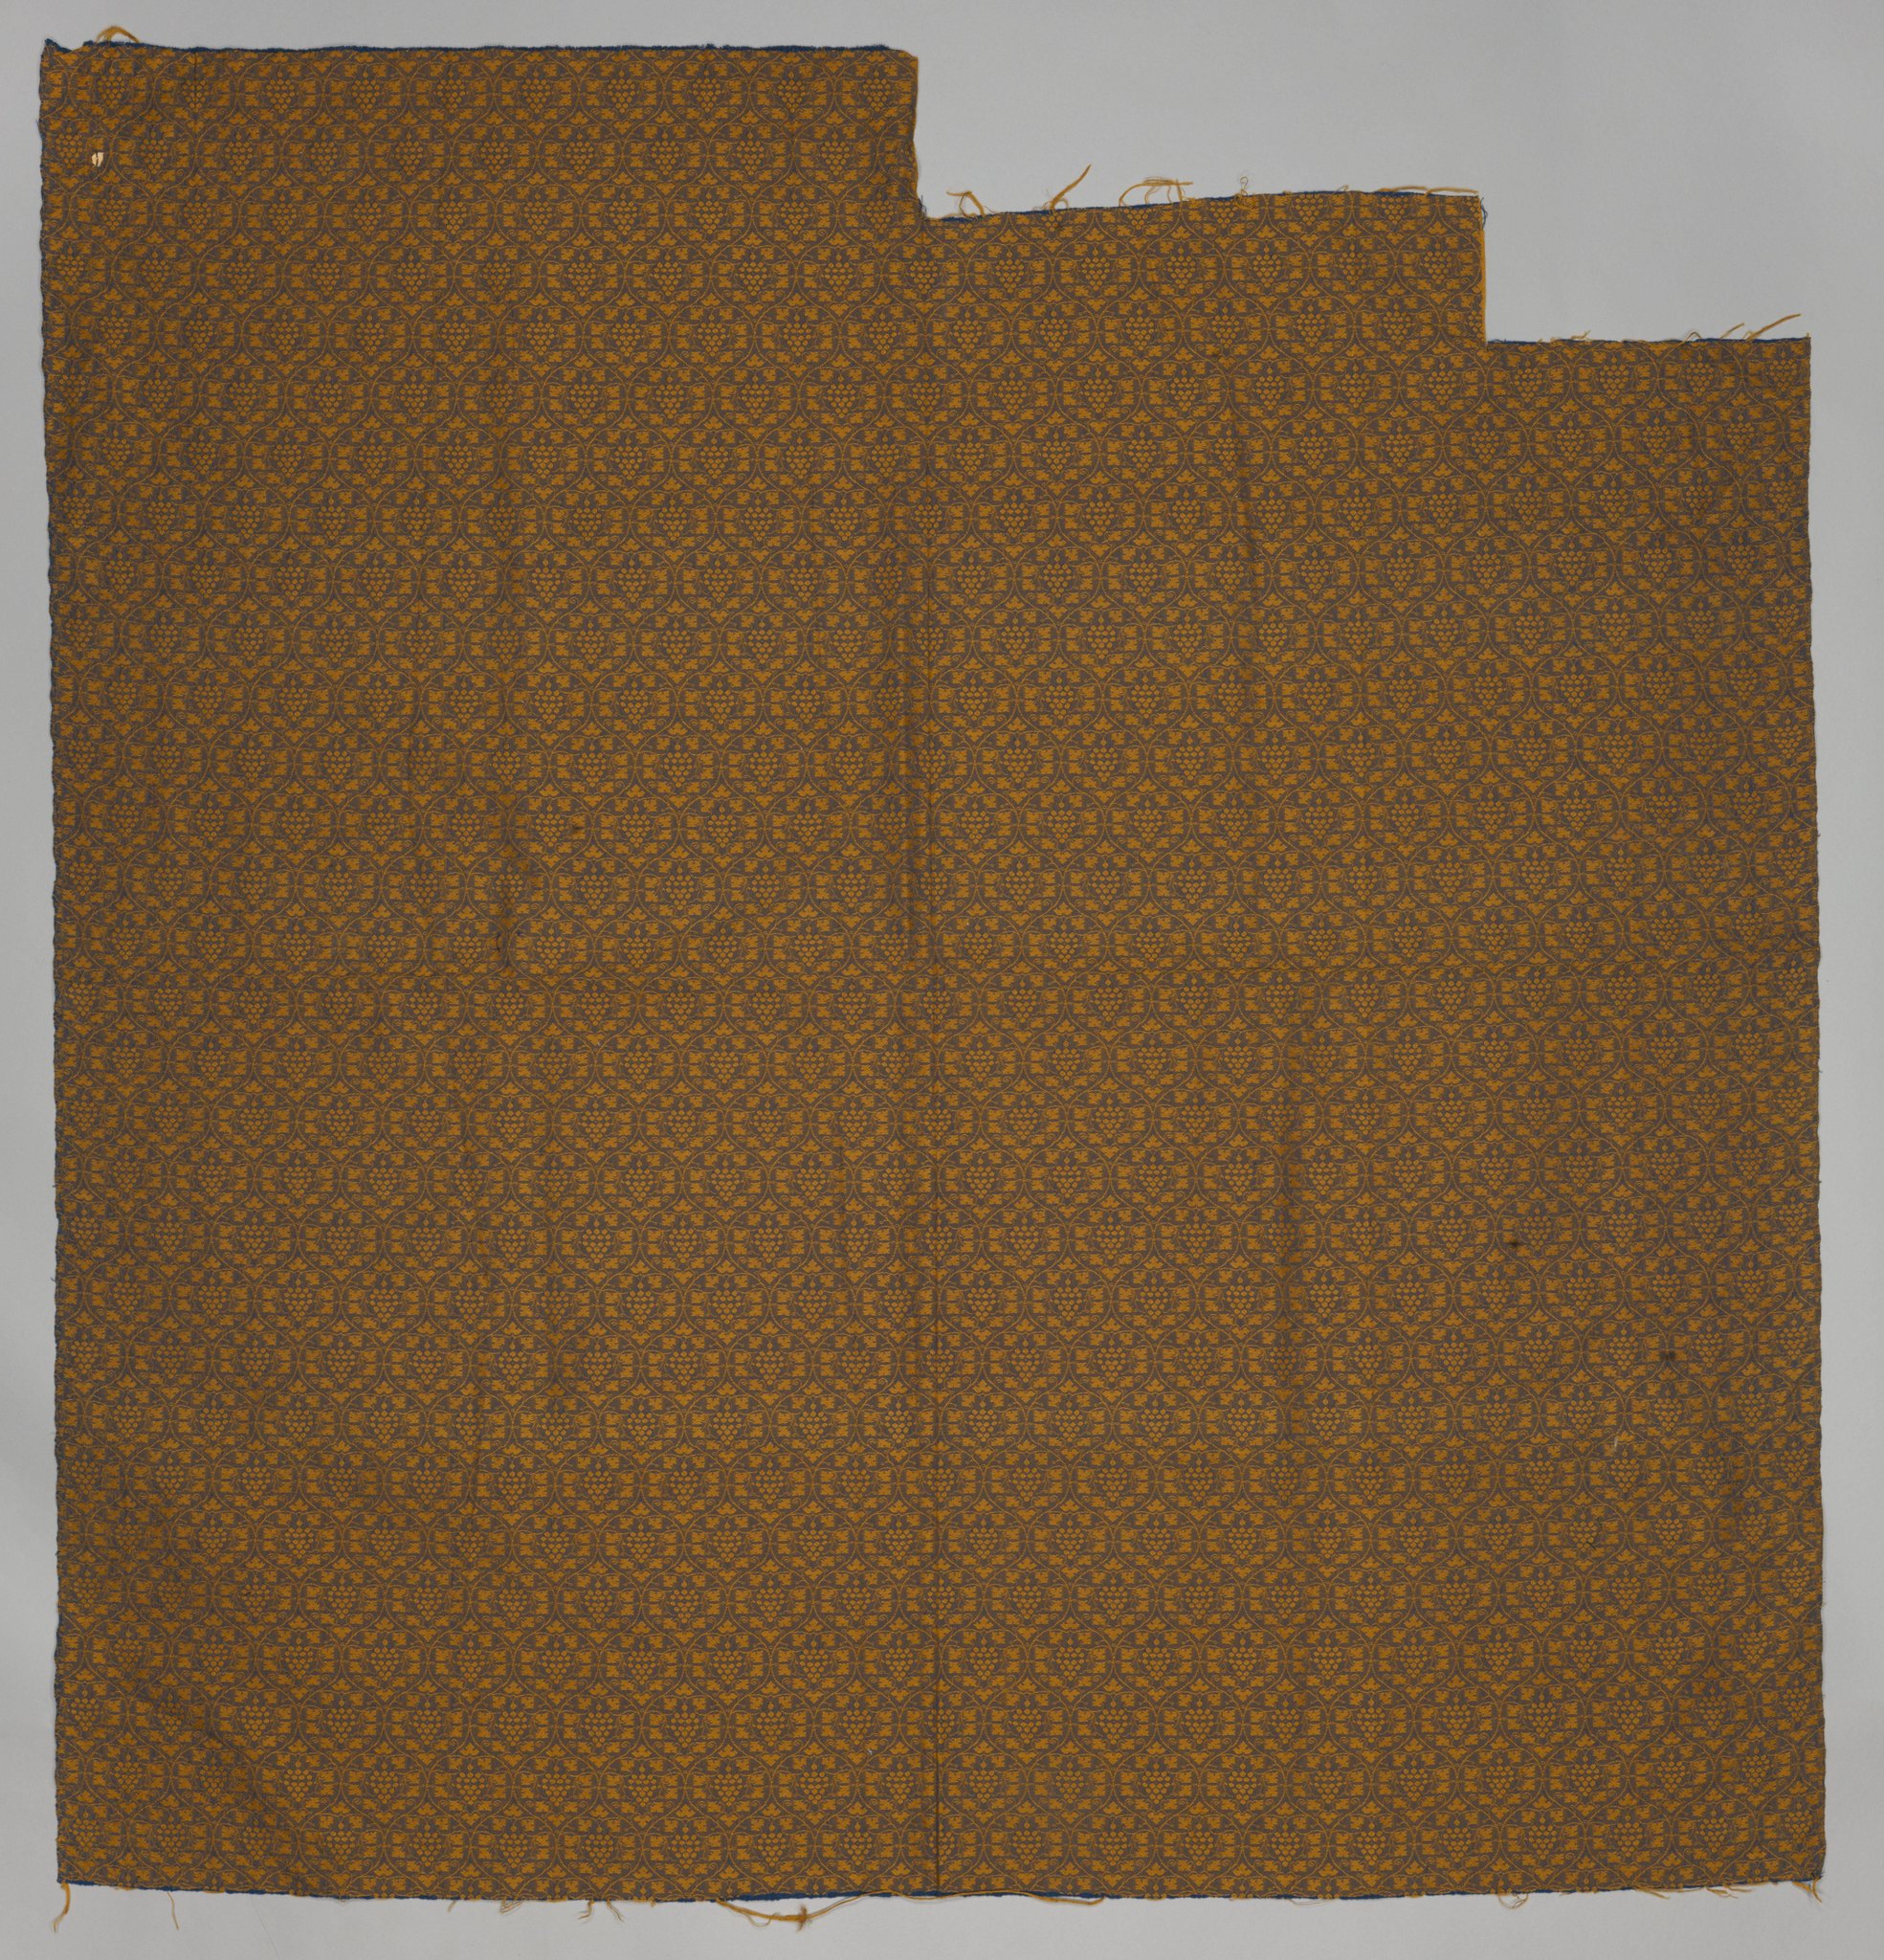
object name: upholstery fabric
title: Bespanningsstof, jacquardweefsel met patroon van spitsovalen met wingerdranken, goudgele inslag op blauwe ketting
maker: theo nieuwenhuis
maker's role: designer, draughtsman, print maker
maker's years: 1866-1951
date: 1920-1930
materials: wool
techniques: jacquard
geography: helmond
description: Bespanningsstof, jacquardweefsel met patroon van spitsovalen met wingerdranken, gougele inslag op blauwe ketting.